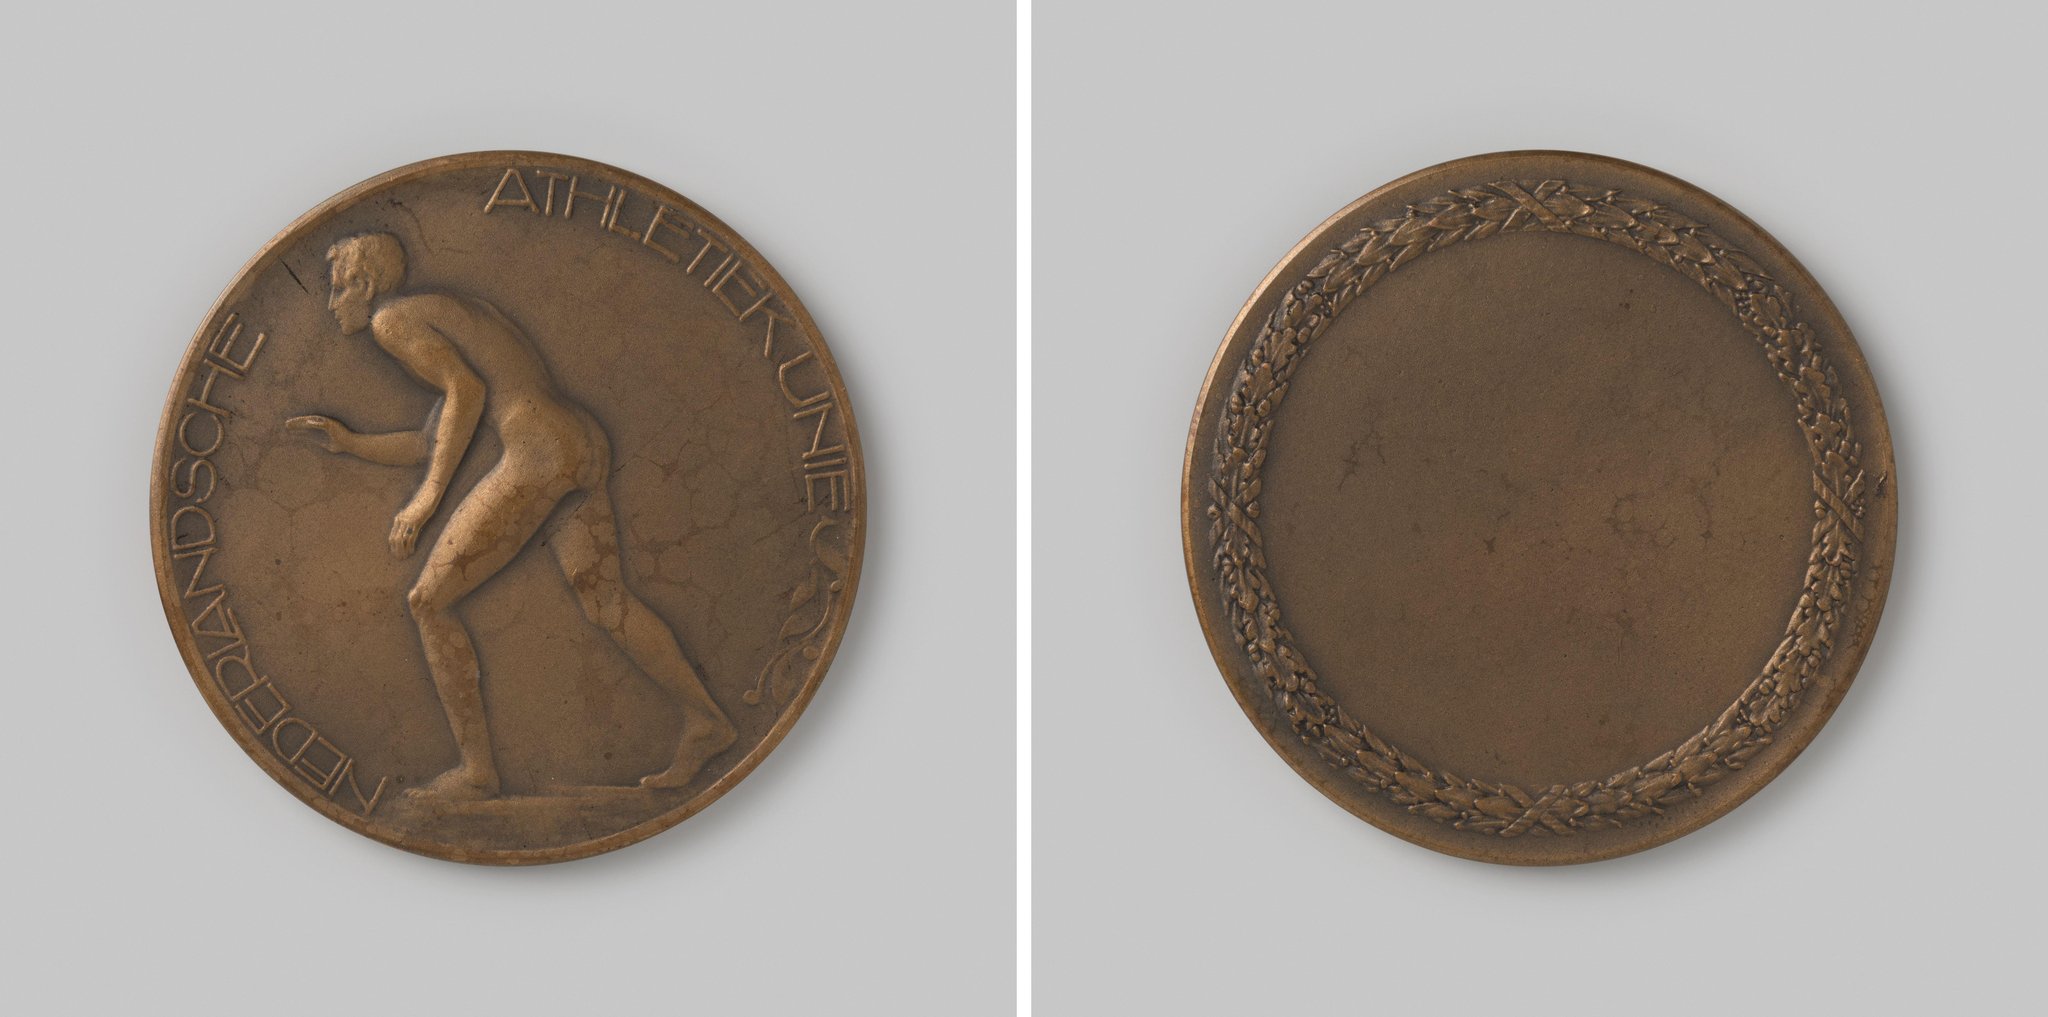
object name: history medal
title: Prijspenning van de Nederlandsche Athletiek Unie (1922)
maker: chris van der hoef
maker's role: ceramicist, draughtsman, sculptor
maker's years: 1875-1933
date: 1922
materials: bronze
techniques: striking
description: Bronzen penning, op de voorzijde een atleet naar links, half van achteren, met omschrift, op de keerzijde een inscriptieruimte binnen een eiken- en lauwerkrans.